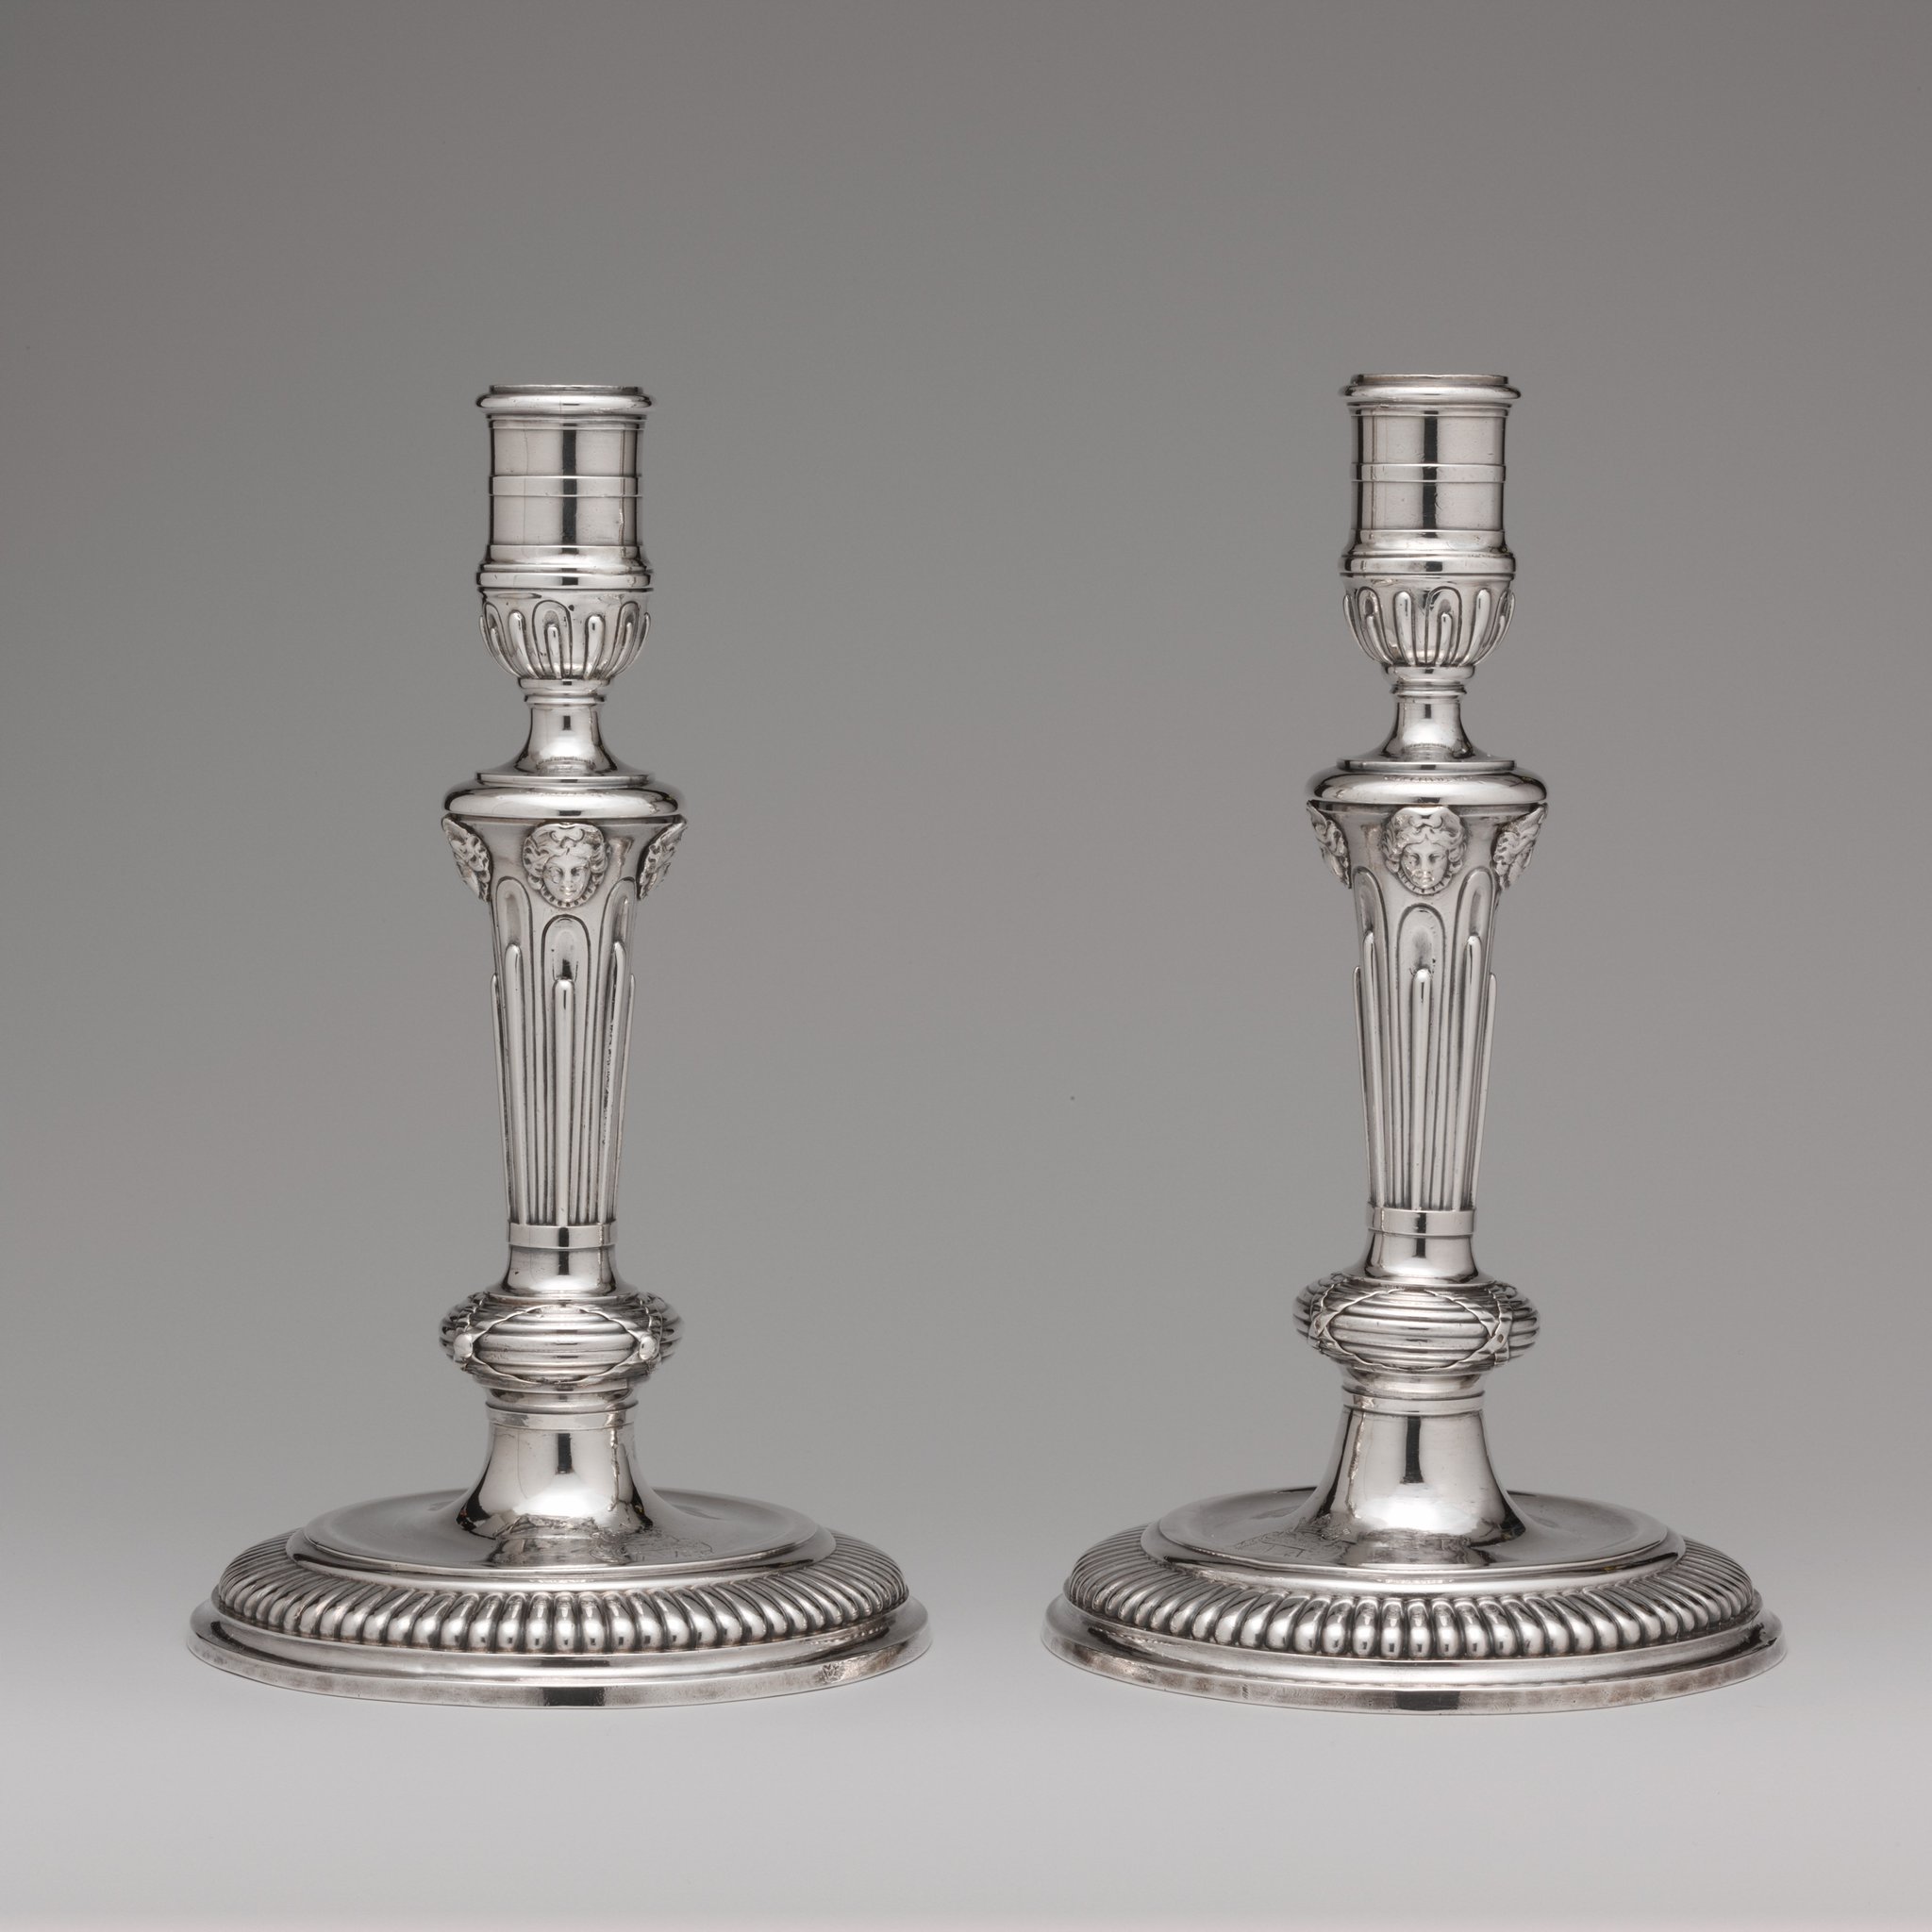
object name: candlestick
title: Pair of candlesticks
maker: charles petit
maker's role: maker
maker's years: 1629-1725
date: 1701-1702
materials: silver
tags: coat of arms